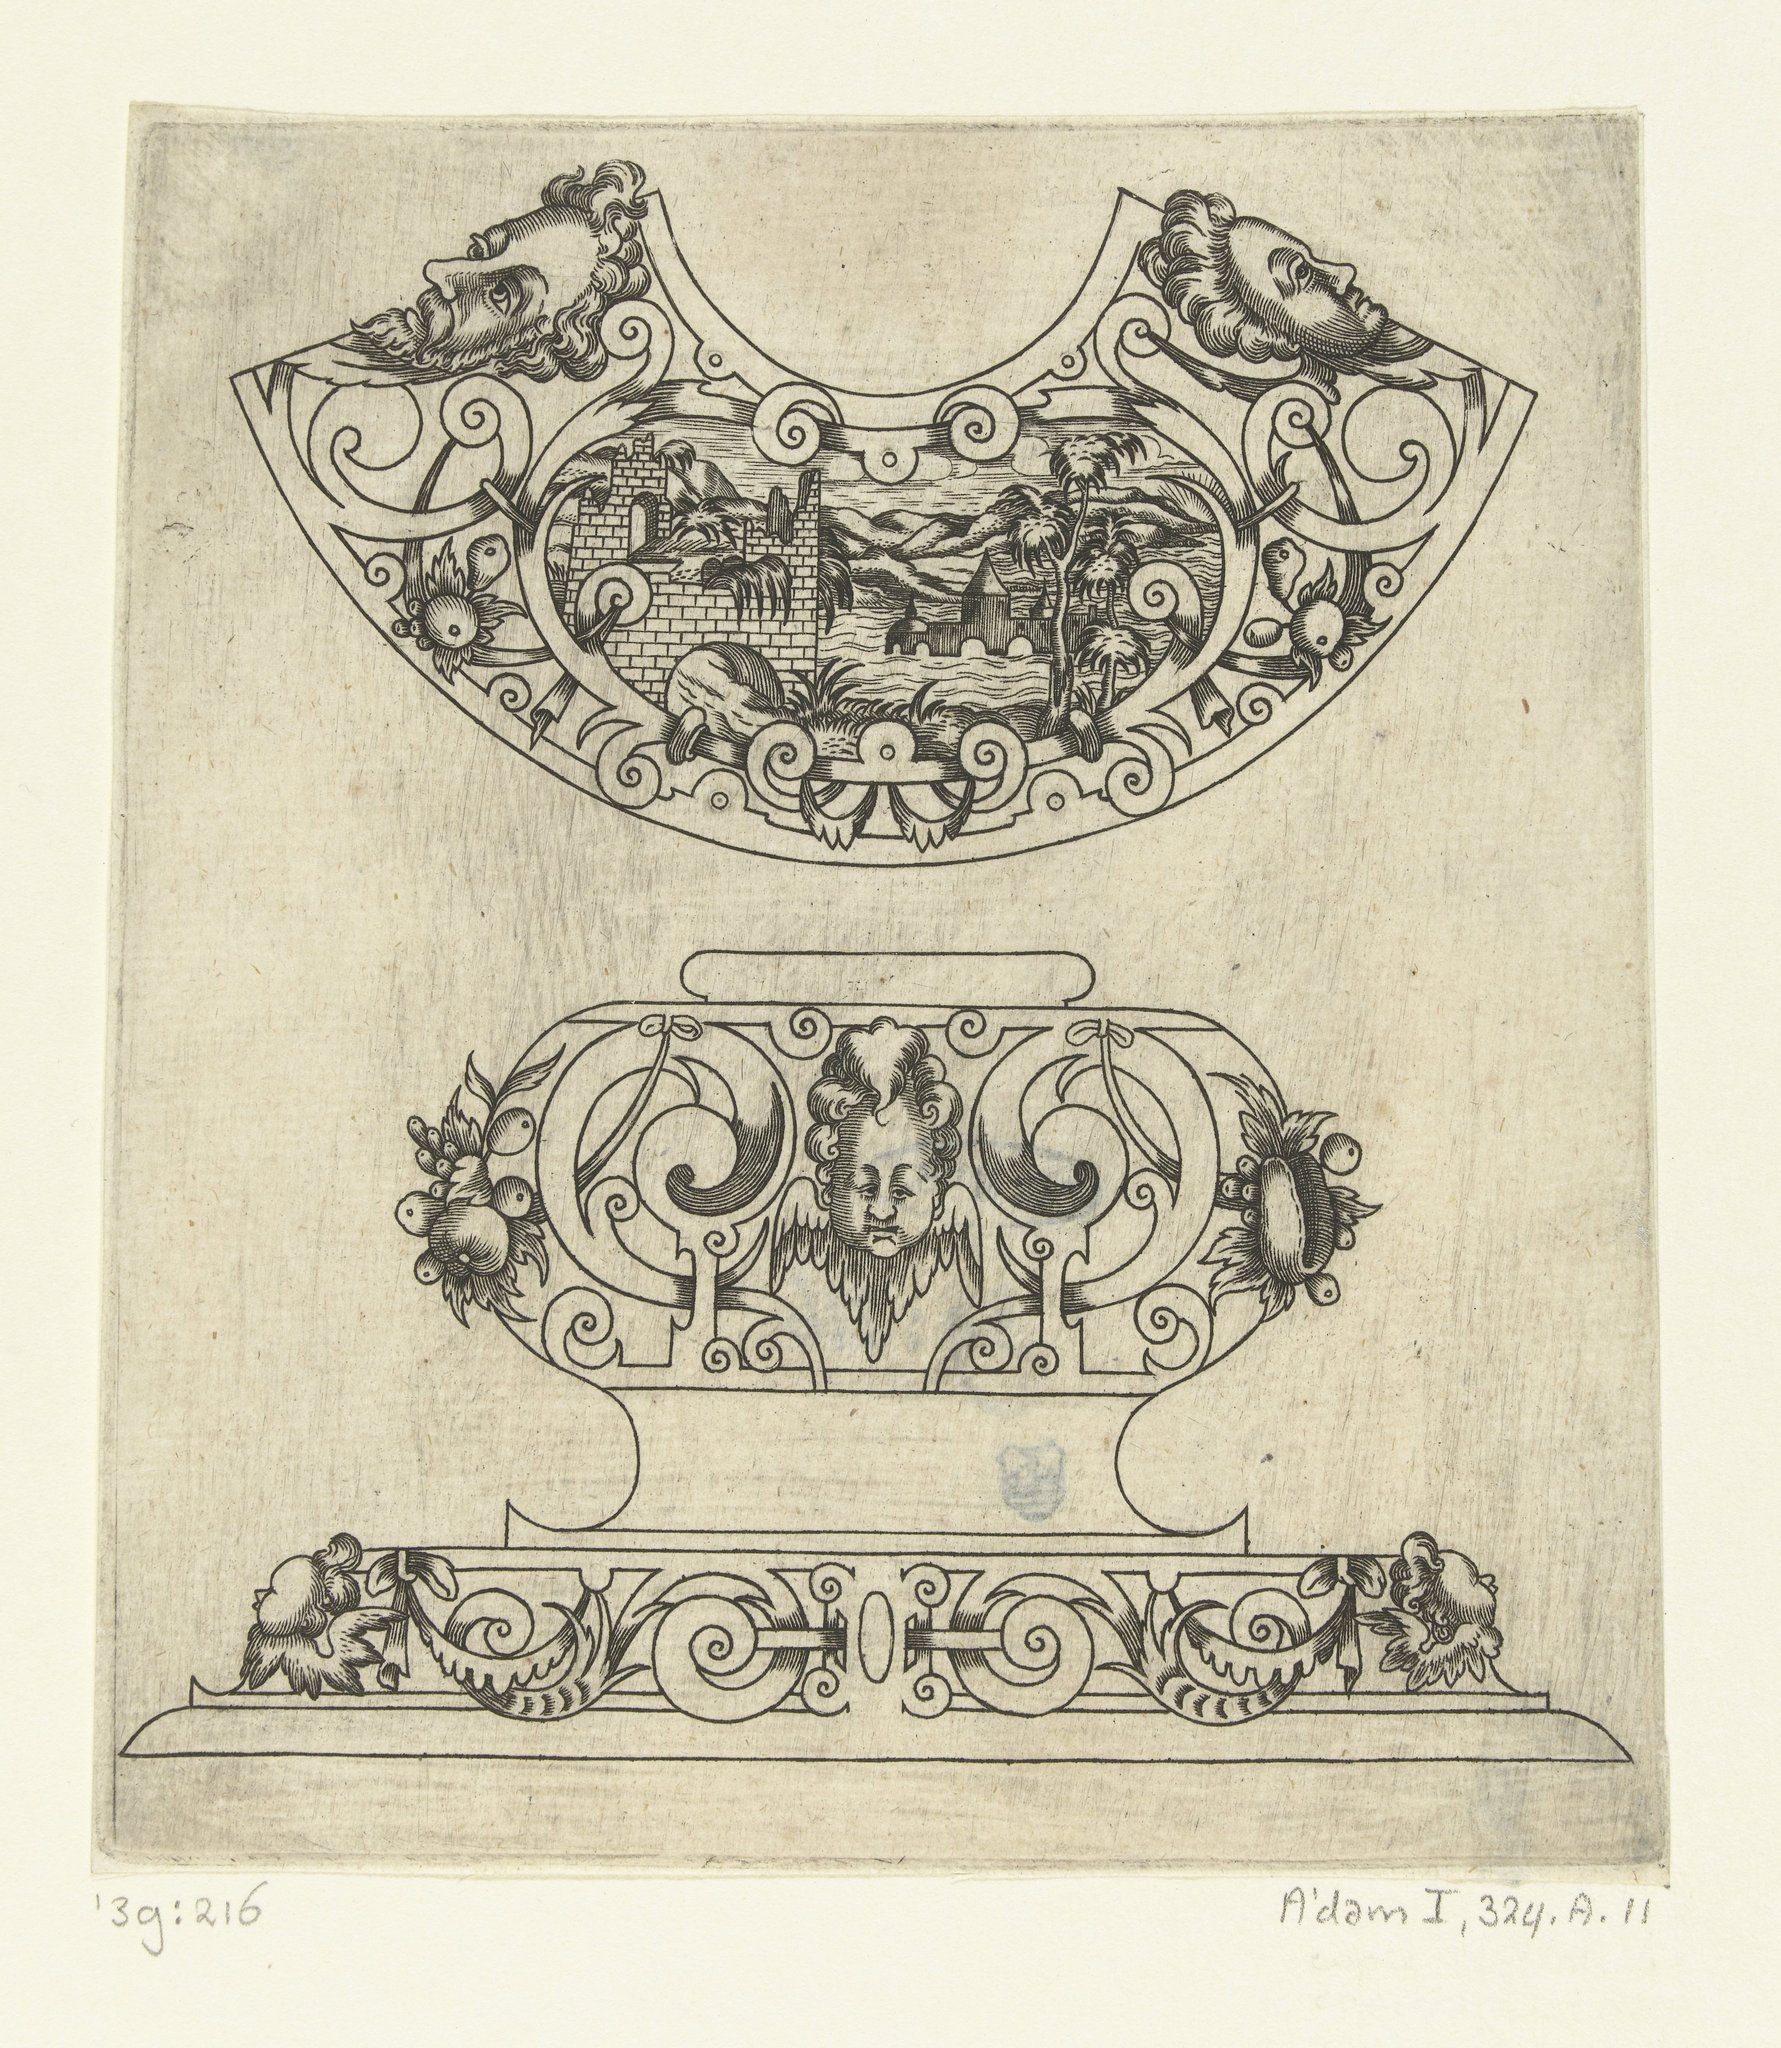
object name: print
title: Voet van een schaal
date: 1500-1598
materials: paper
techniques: engraving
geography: germany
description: De decoratie van de bovenzijde van de voet, bestaande uit een landschap in een liggend ovaal tussen twee mascarons, is boven de voet als een gebogen fries weergegeven. Gelijkzijdige kopieën van de onder Orn Cat I-324 vermelde serie. Titelblad en 13 bladen.